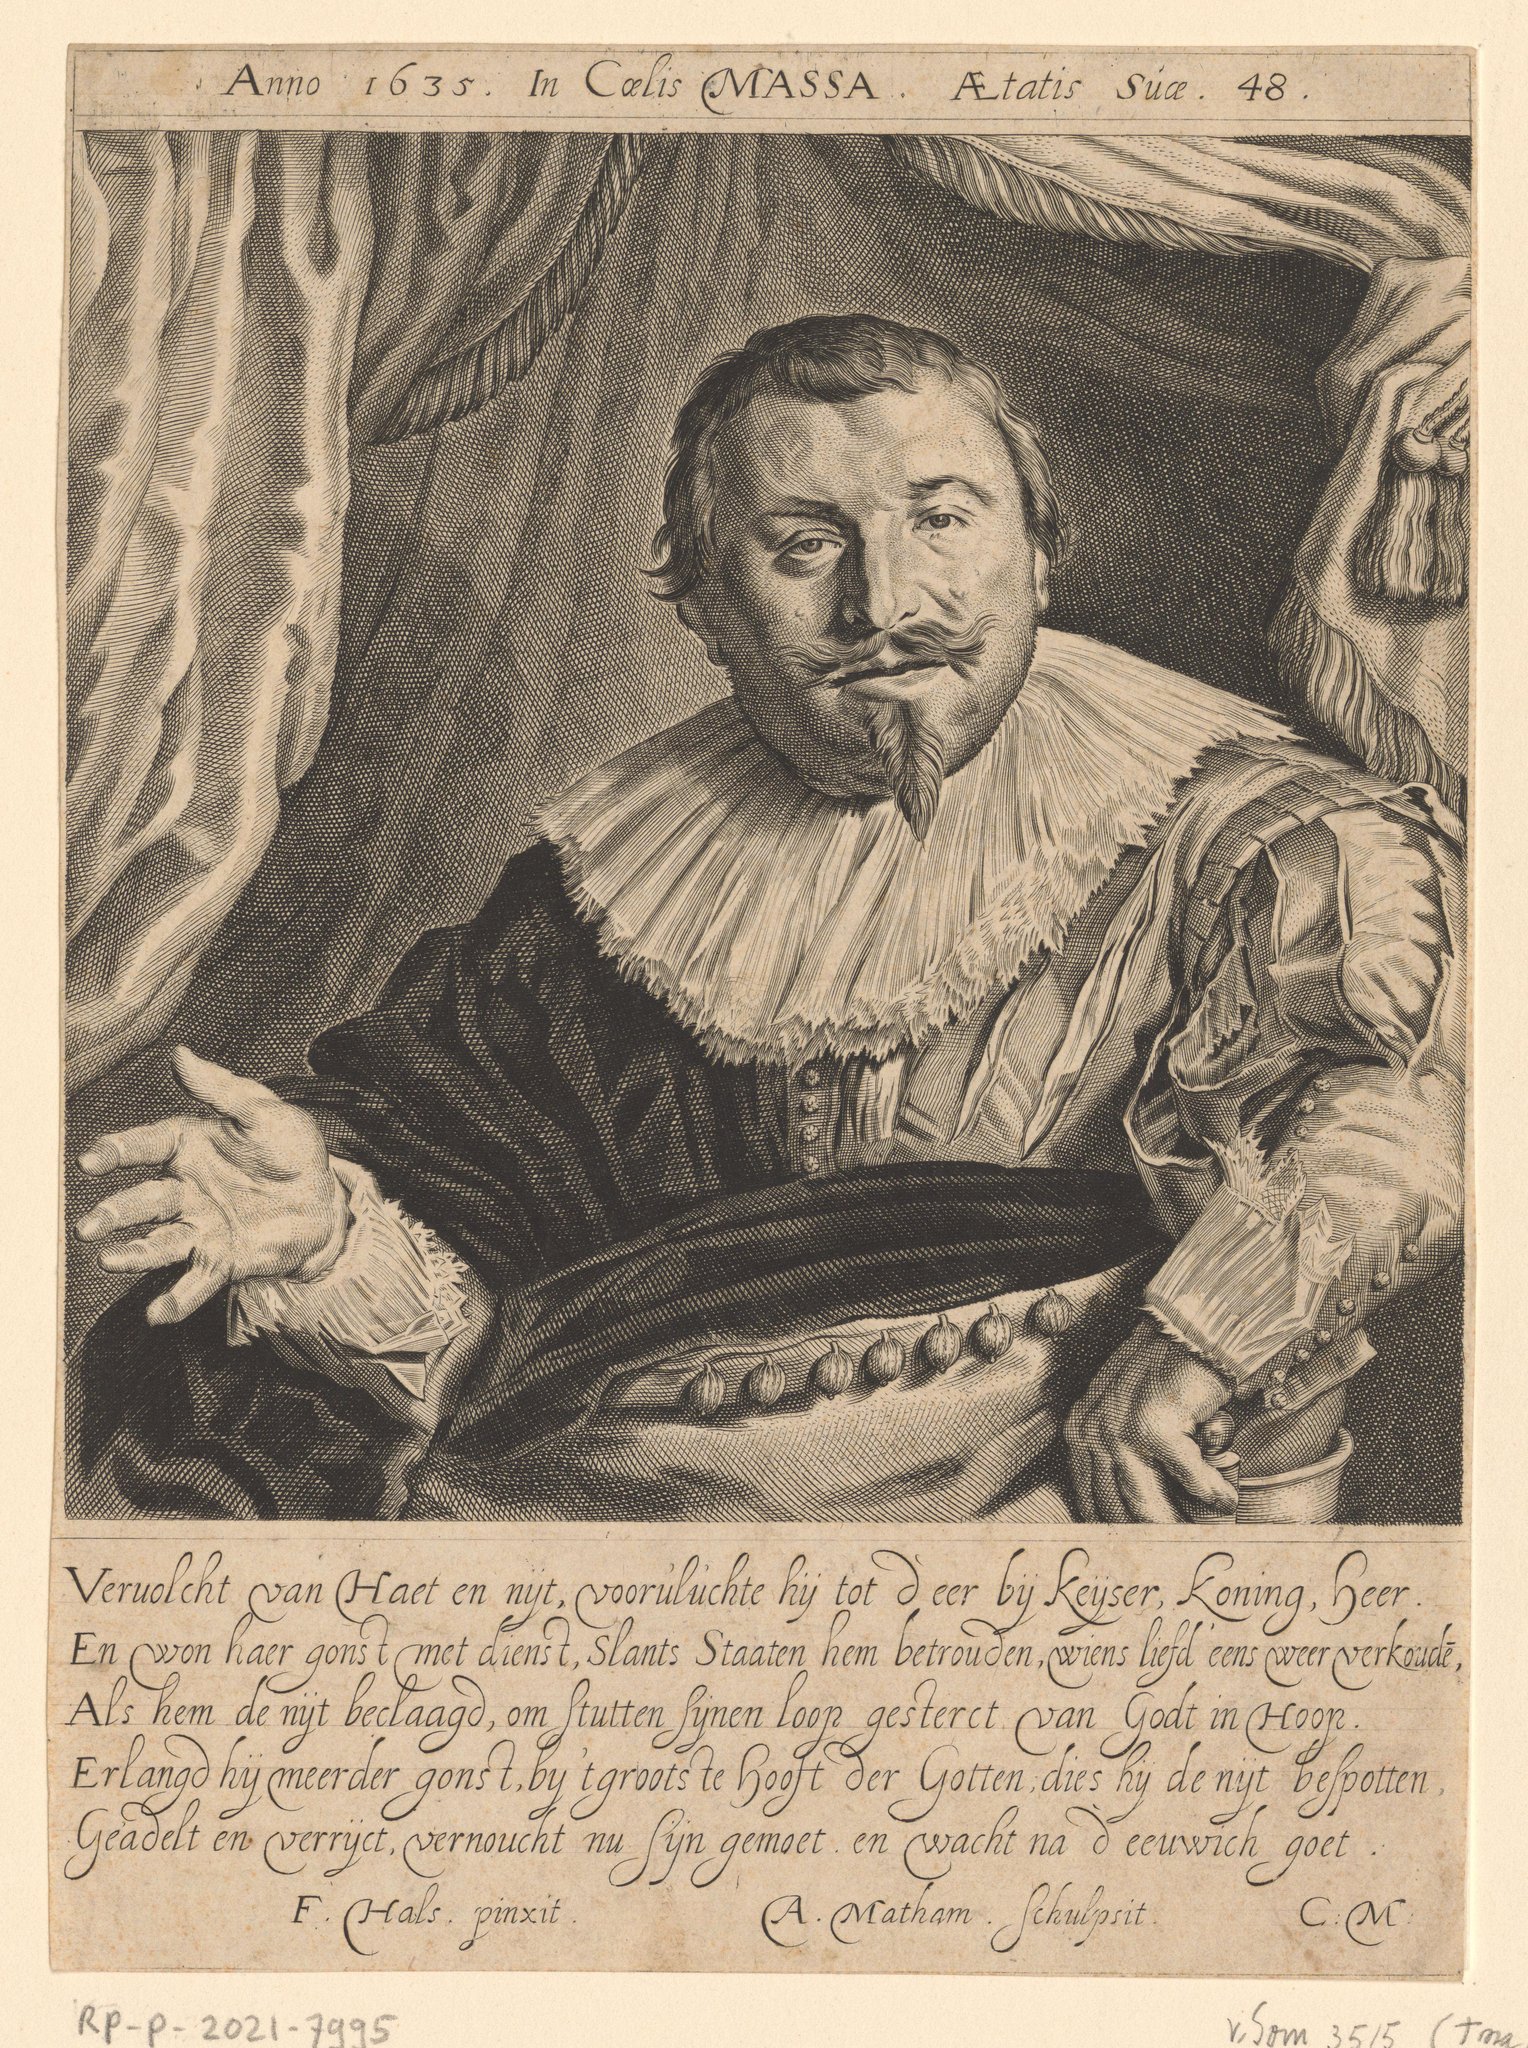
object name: print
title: Portret van Isaac Abrahamsz. Massa op 48-jarige leeftijd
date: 1643-1660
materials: paper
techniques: engraving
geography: haarlem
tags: historical persons, merchant, salesman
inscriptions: collector's mark: Lugt 240, number: ‘AP256’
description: Met vijfregelig lofdicht in het Nederlands onder het portret.